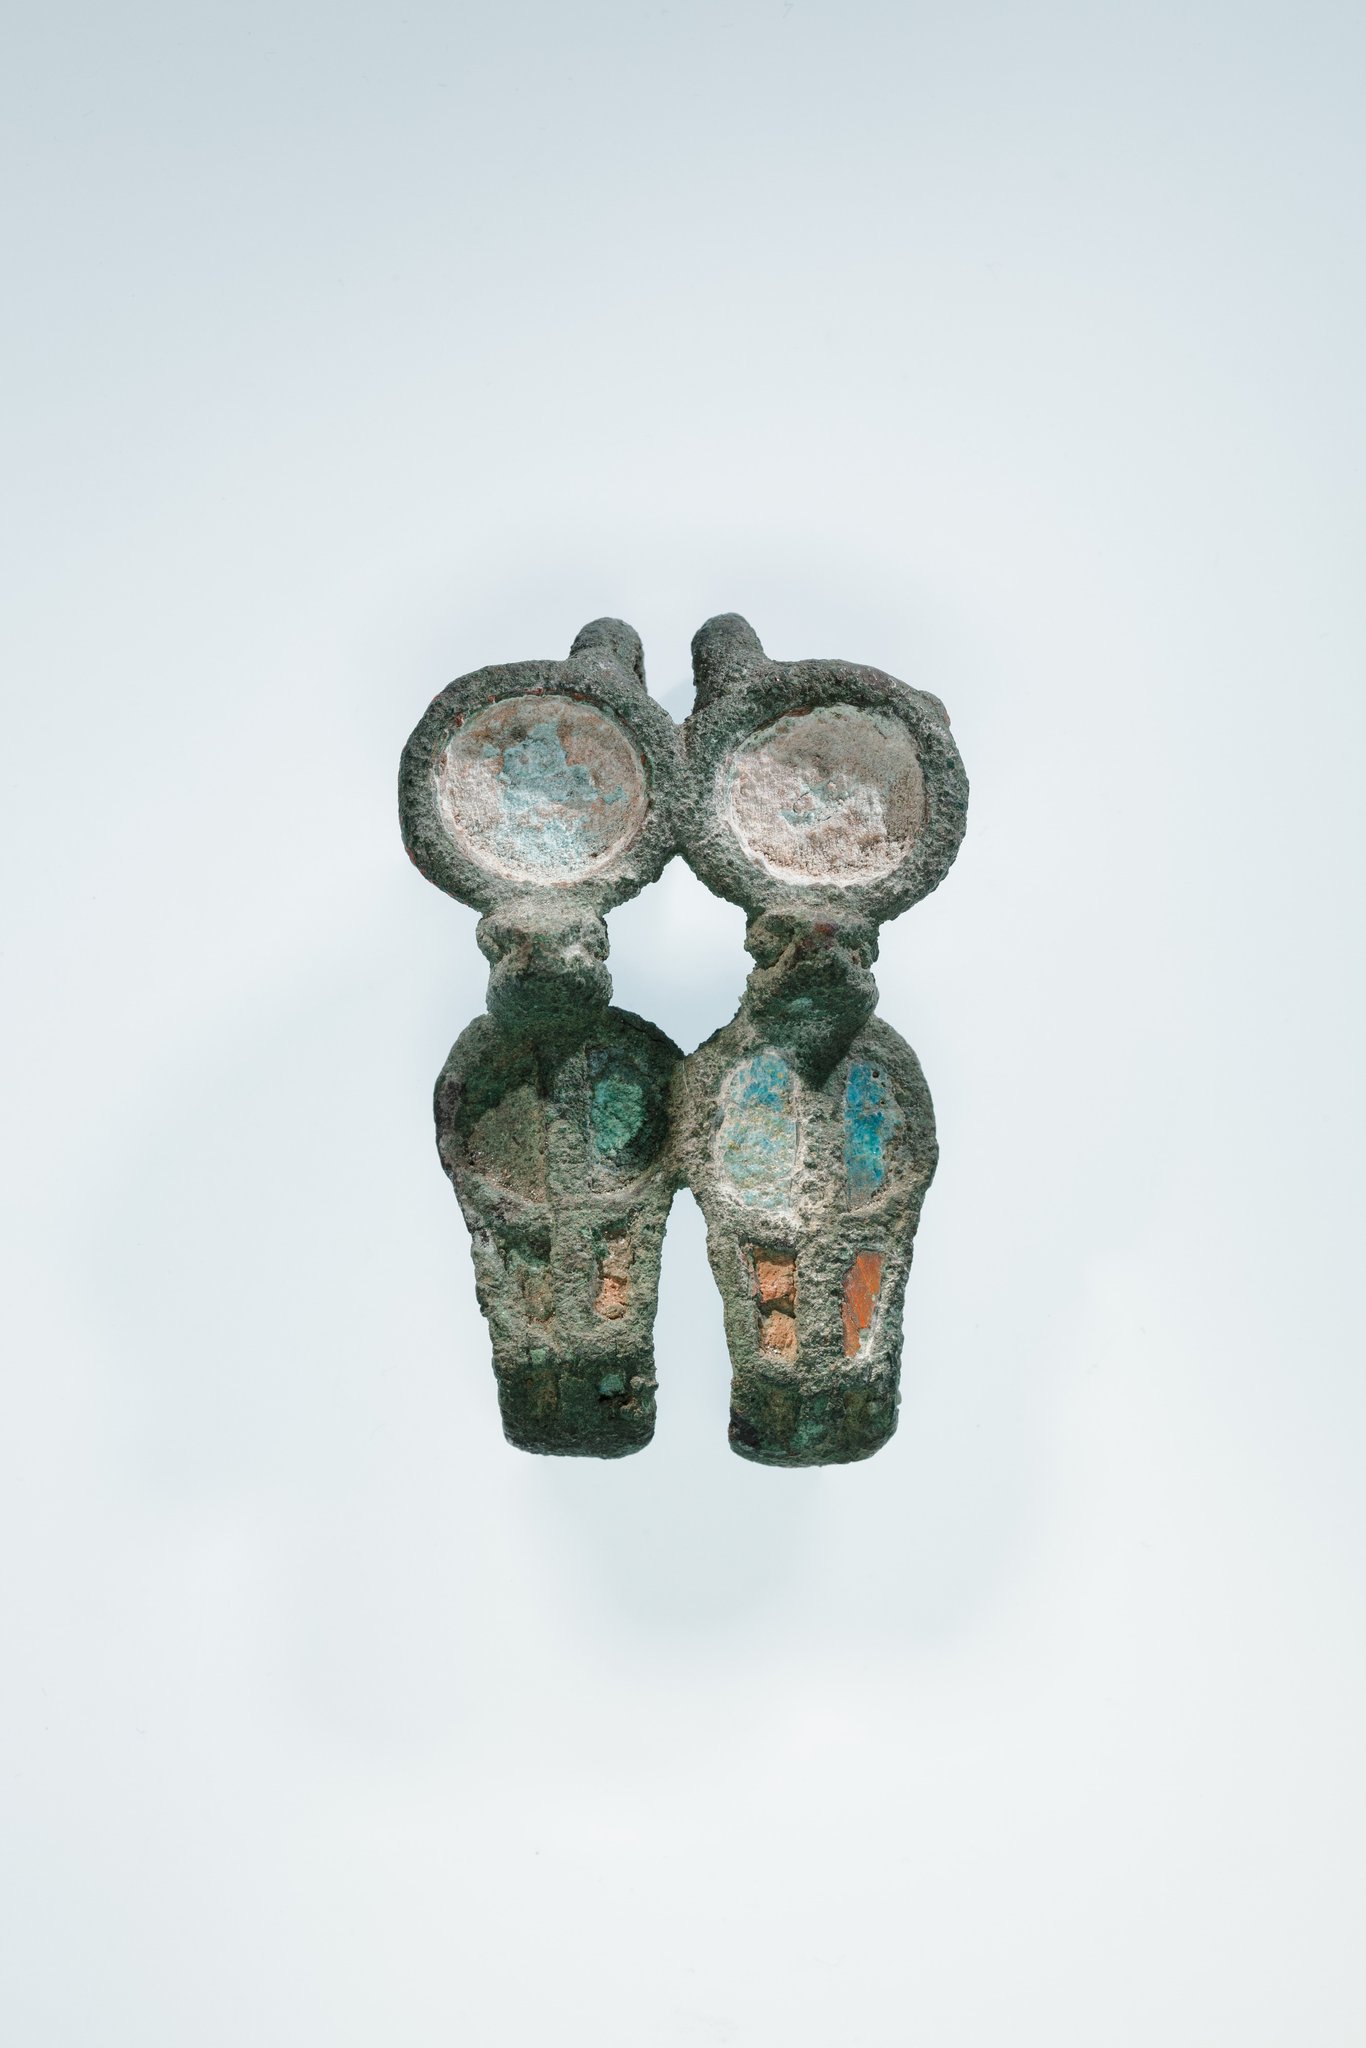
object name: attachment, double uraei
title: Double uraeus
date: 664-630 BCE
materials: bronze, glass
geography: egypt